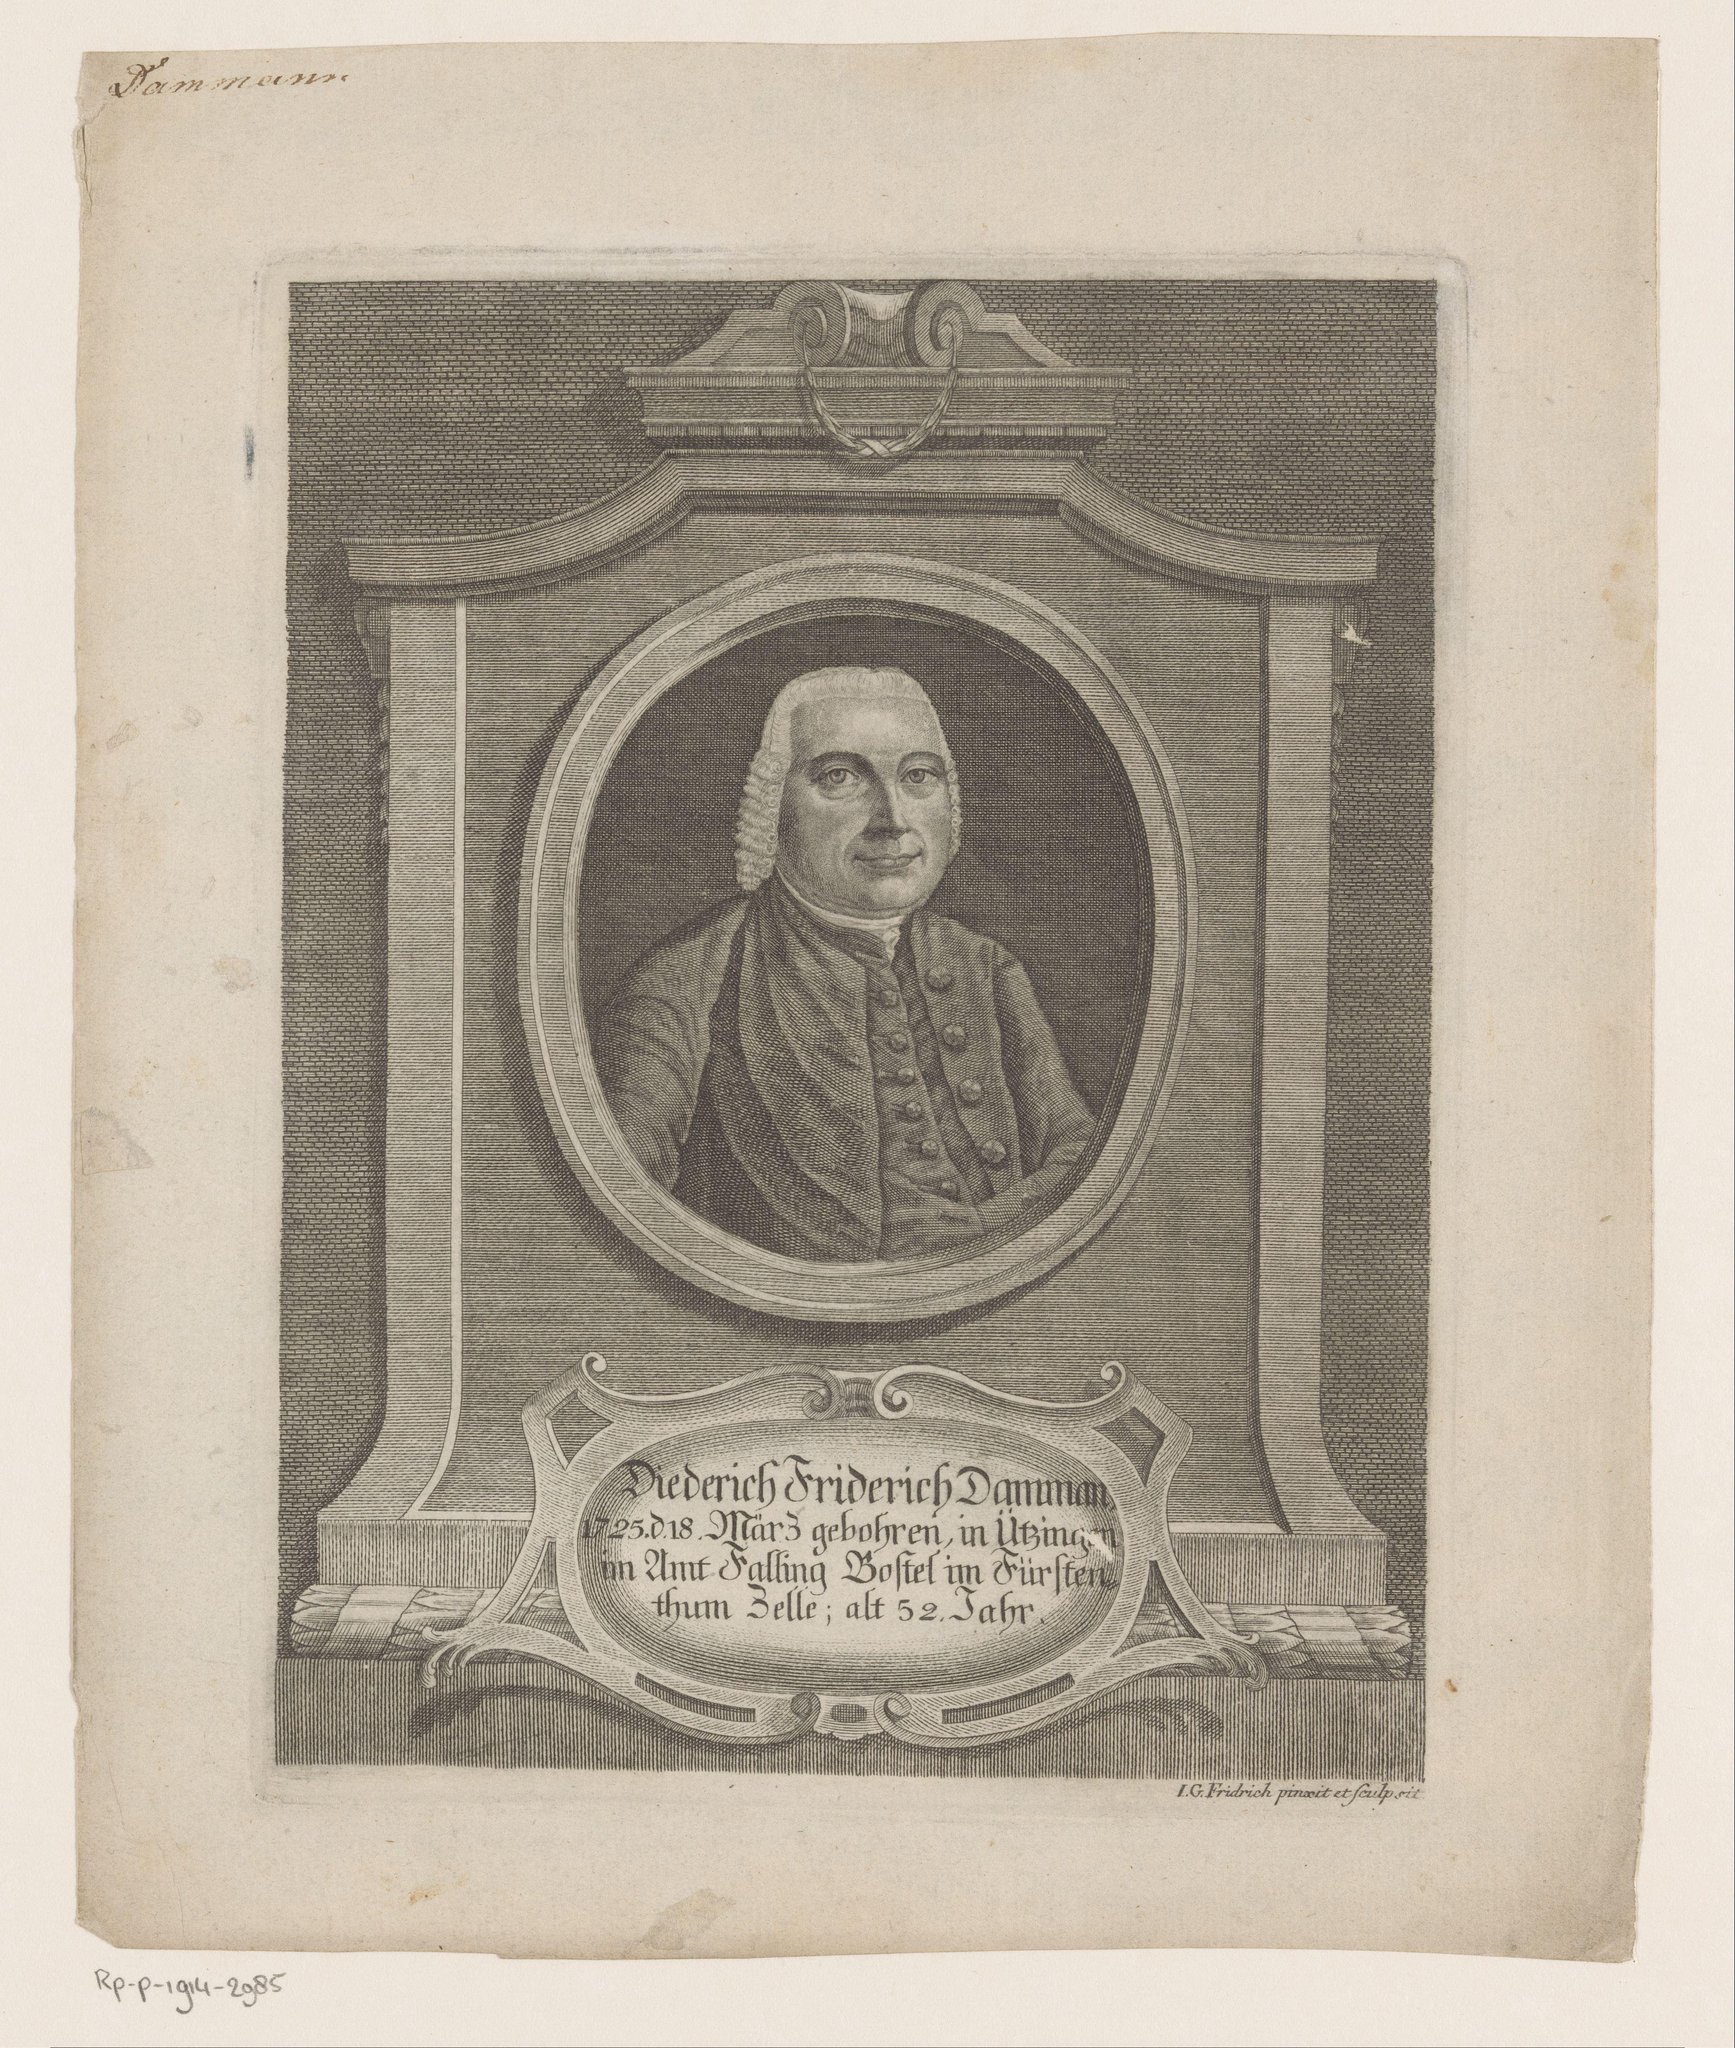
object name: print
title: Portret van Diederich Friderich Damman op 52-jarige leeftijd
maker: johann gottlieb fridrich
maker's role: print maker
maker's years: 1742-1809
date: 1777-1809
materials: paper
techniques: engraving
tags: historical persons, ornament ~ cartouche, ornament derived from architectural details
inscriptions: collector's mark: Lugt 2228